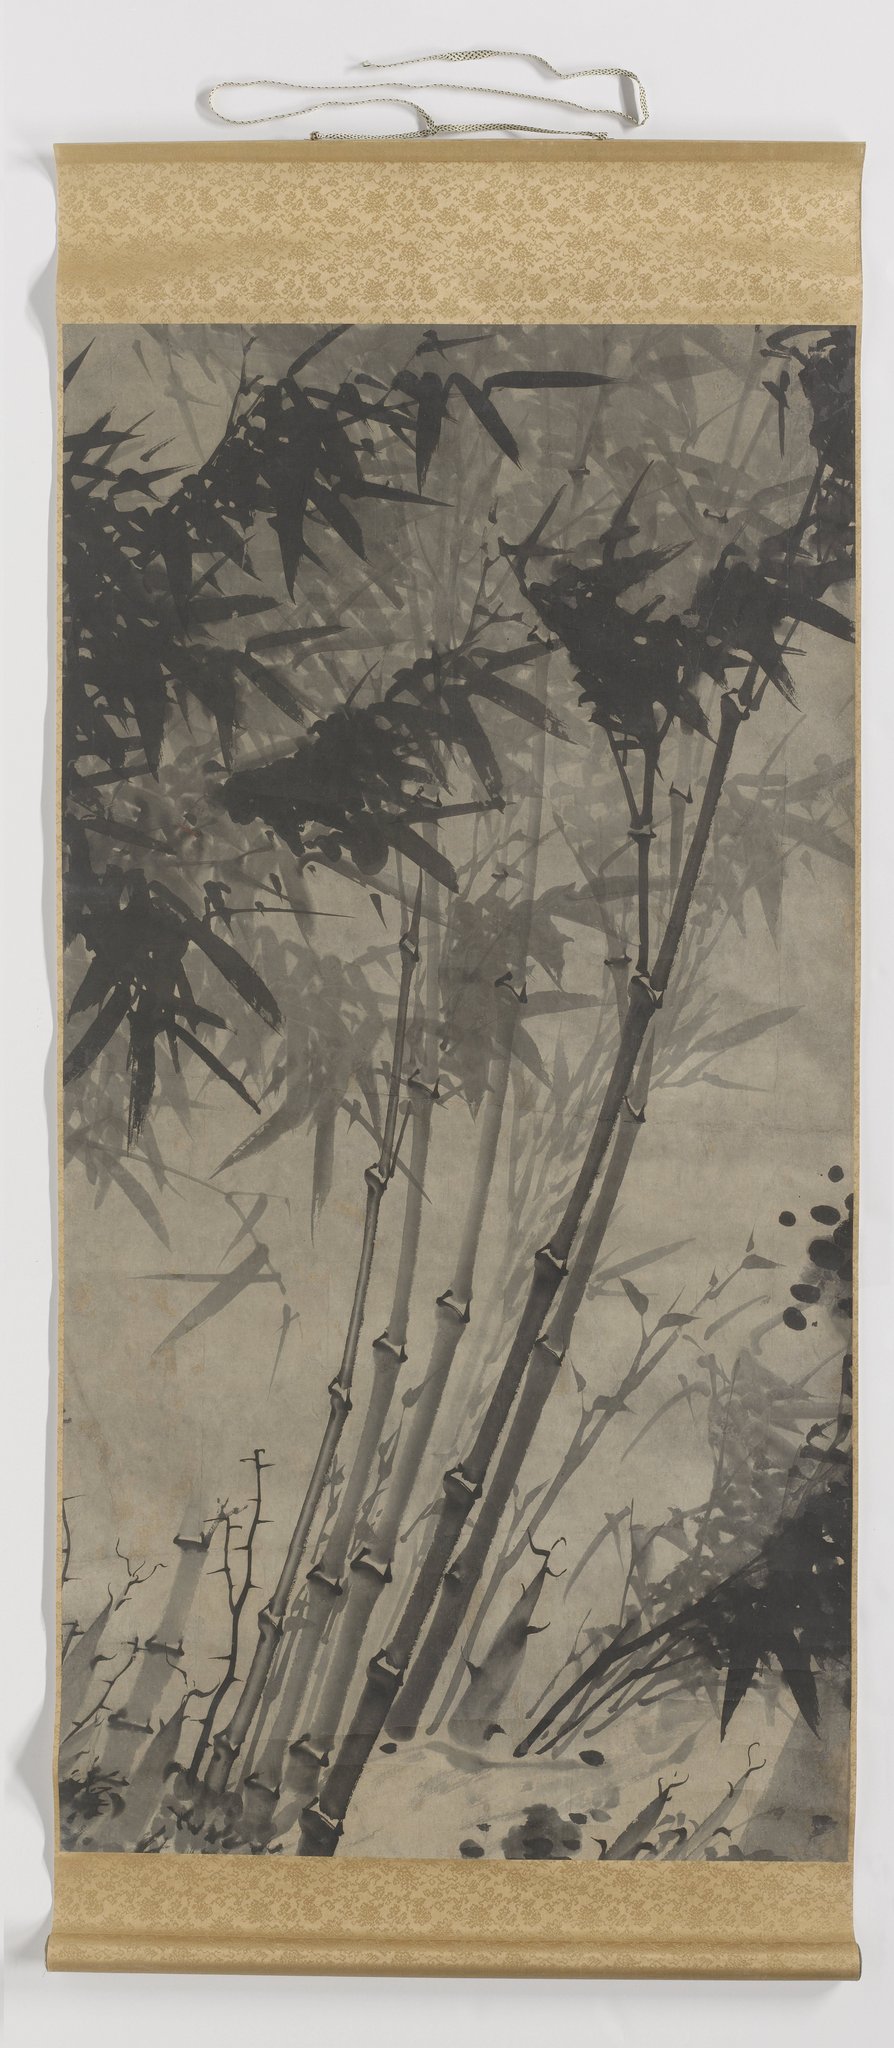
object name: hanging scroll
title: Bamboo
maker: zhengxing (bijnaam wuzhai)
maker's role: painter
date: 1675-1750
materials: ink, paper, silk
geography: china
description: These four hanging scrolls are examples of Chinese bamboo painting. Central to this genre is mastery of the brush. The bamboo stem segments as well as the individual leaves are all rendered with just a single brushstroke. The artist worked fairly wet and, in addition to grey tints, made ample use of an undiluted deep black ink to create an atmosphere of lush and moist vegetation.